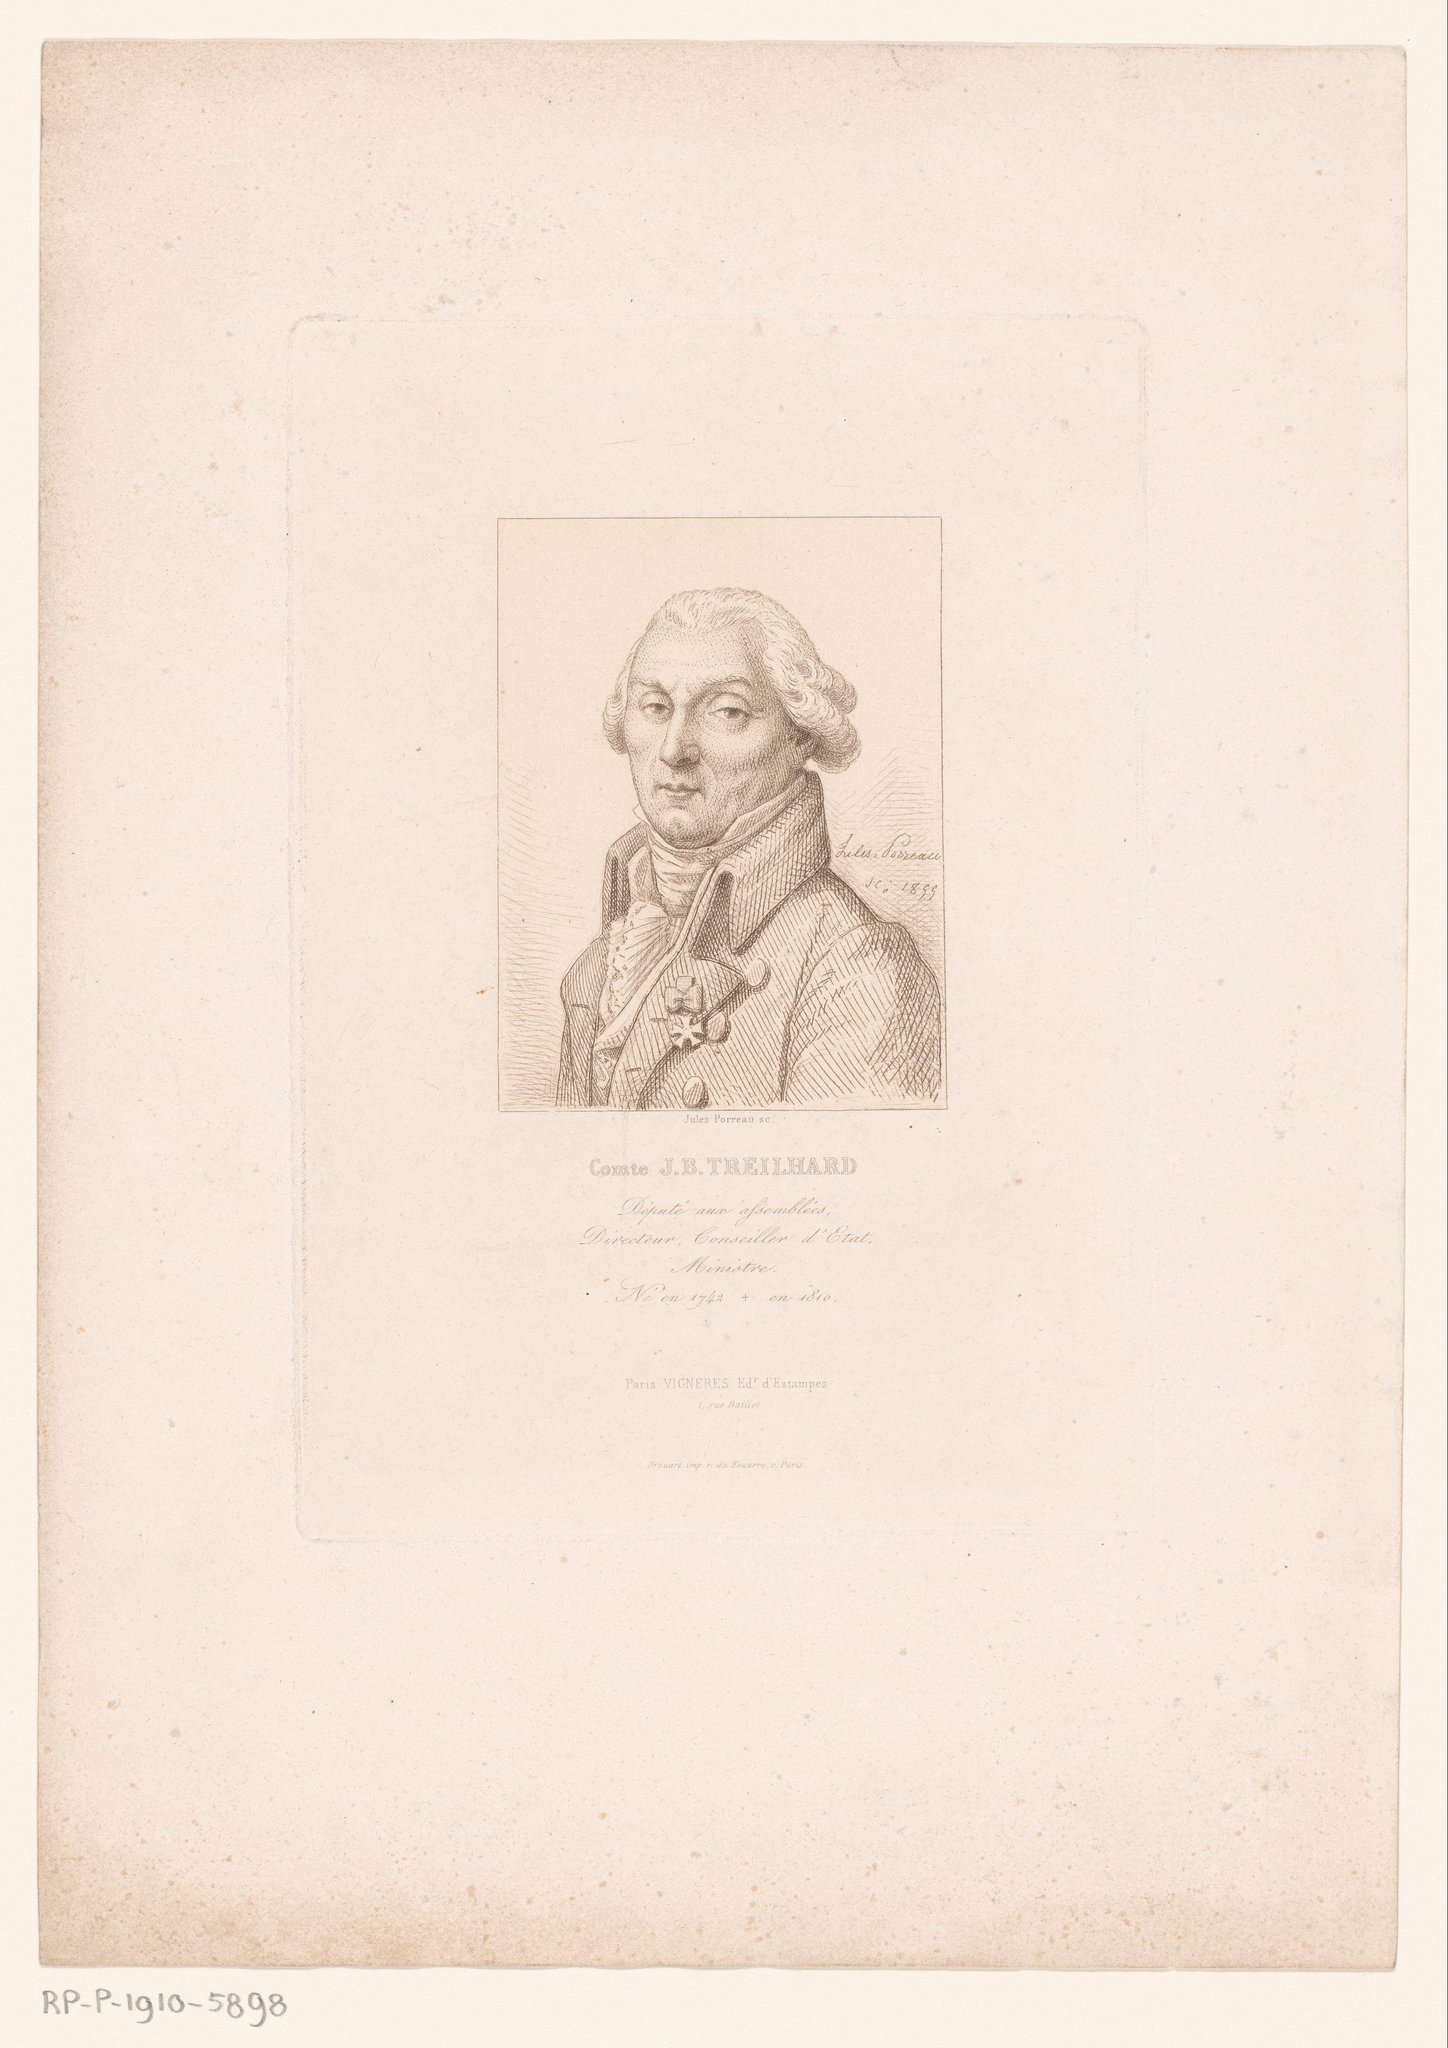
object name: print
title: Portret van Jean Baptiste Treilhard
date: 1899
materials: paper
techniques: etching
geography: paris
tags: paris, politician, historical persons, politician, e.g. party leader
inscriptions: collector's mark: Lugt 2228